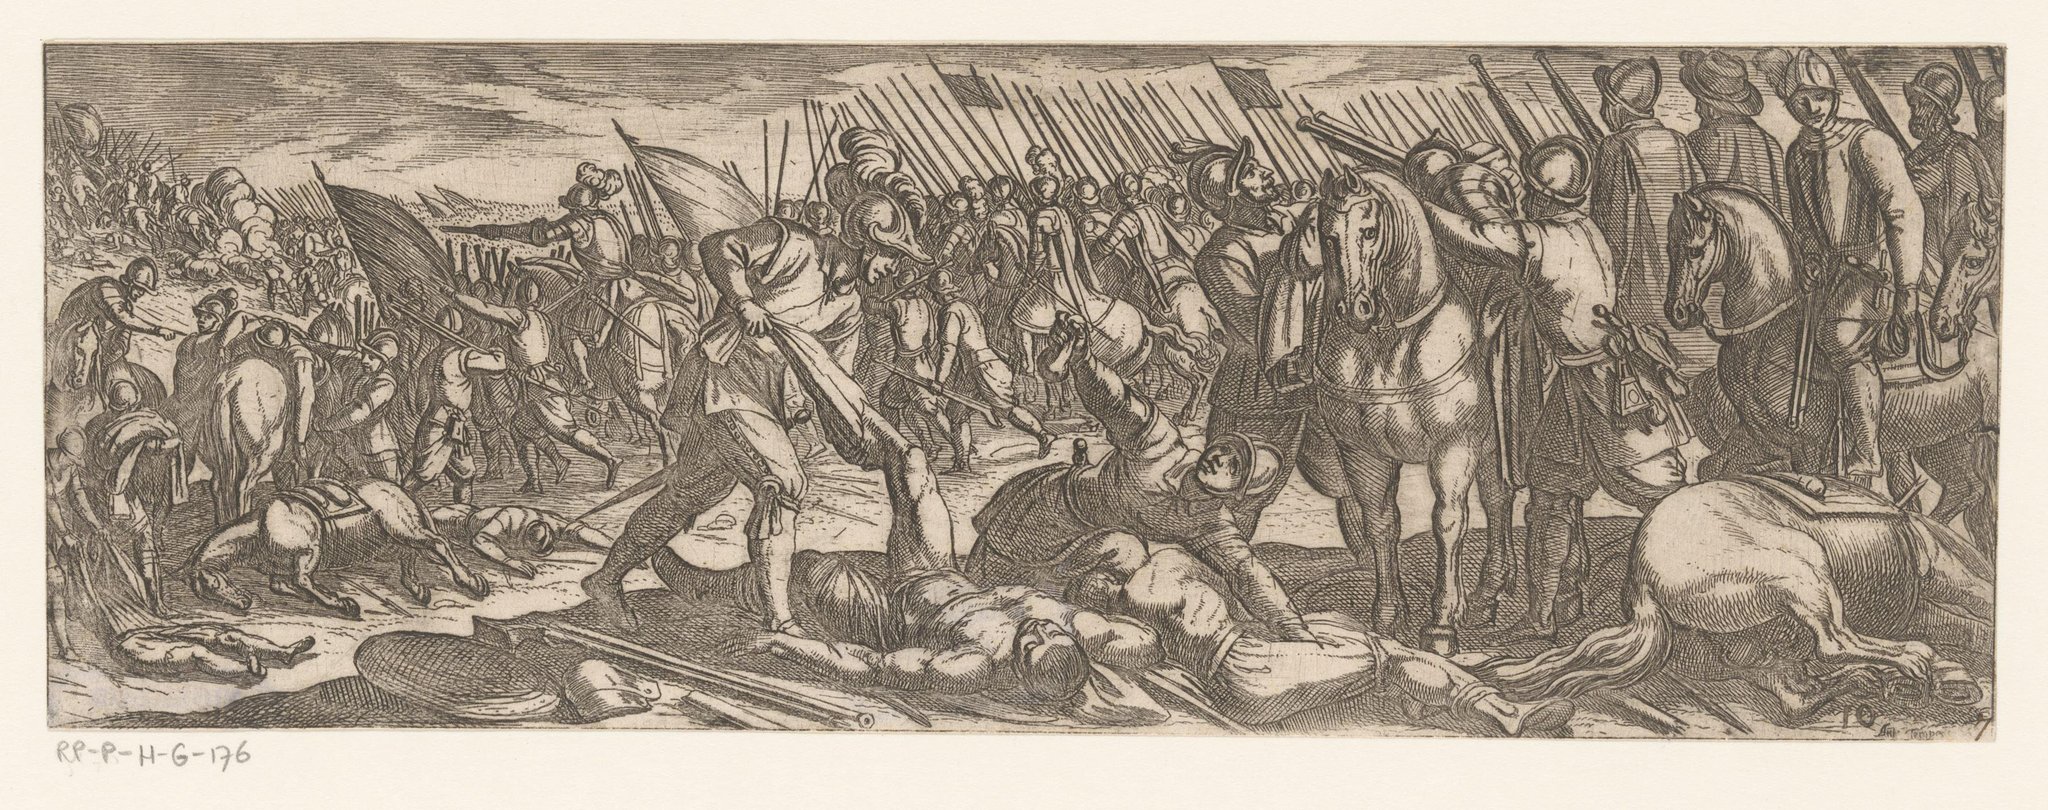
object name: print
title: Overwinnende soldaten stelen de bezittingen van de doden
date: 1599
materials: paper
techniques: etching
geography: italy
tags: warfare; military affairs (+ cavalry, horsemen), the soldier; the soldier's life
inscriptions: collector's mark: ‘Hinloopen’, number: ‘7’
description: Deze prent maakt deel uit van een reeks van 9 prenten (+ titelprent) met gevechtsscènes. Antonio Tempesta maakte ook een eerdere serie met gevechtsscènes van 10 prenten (+titelprent).